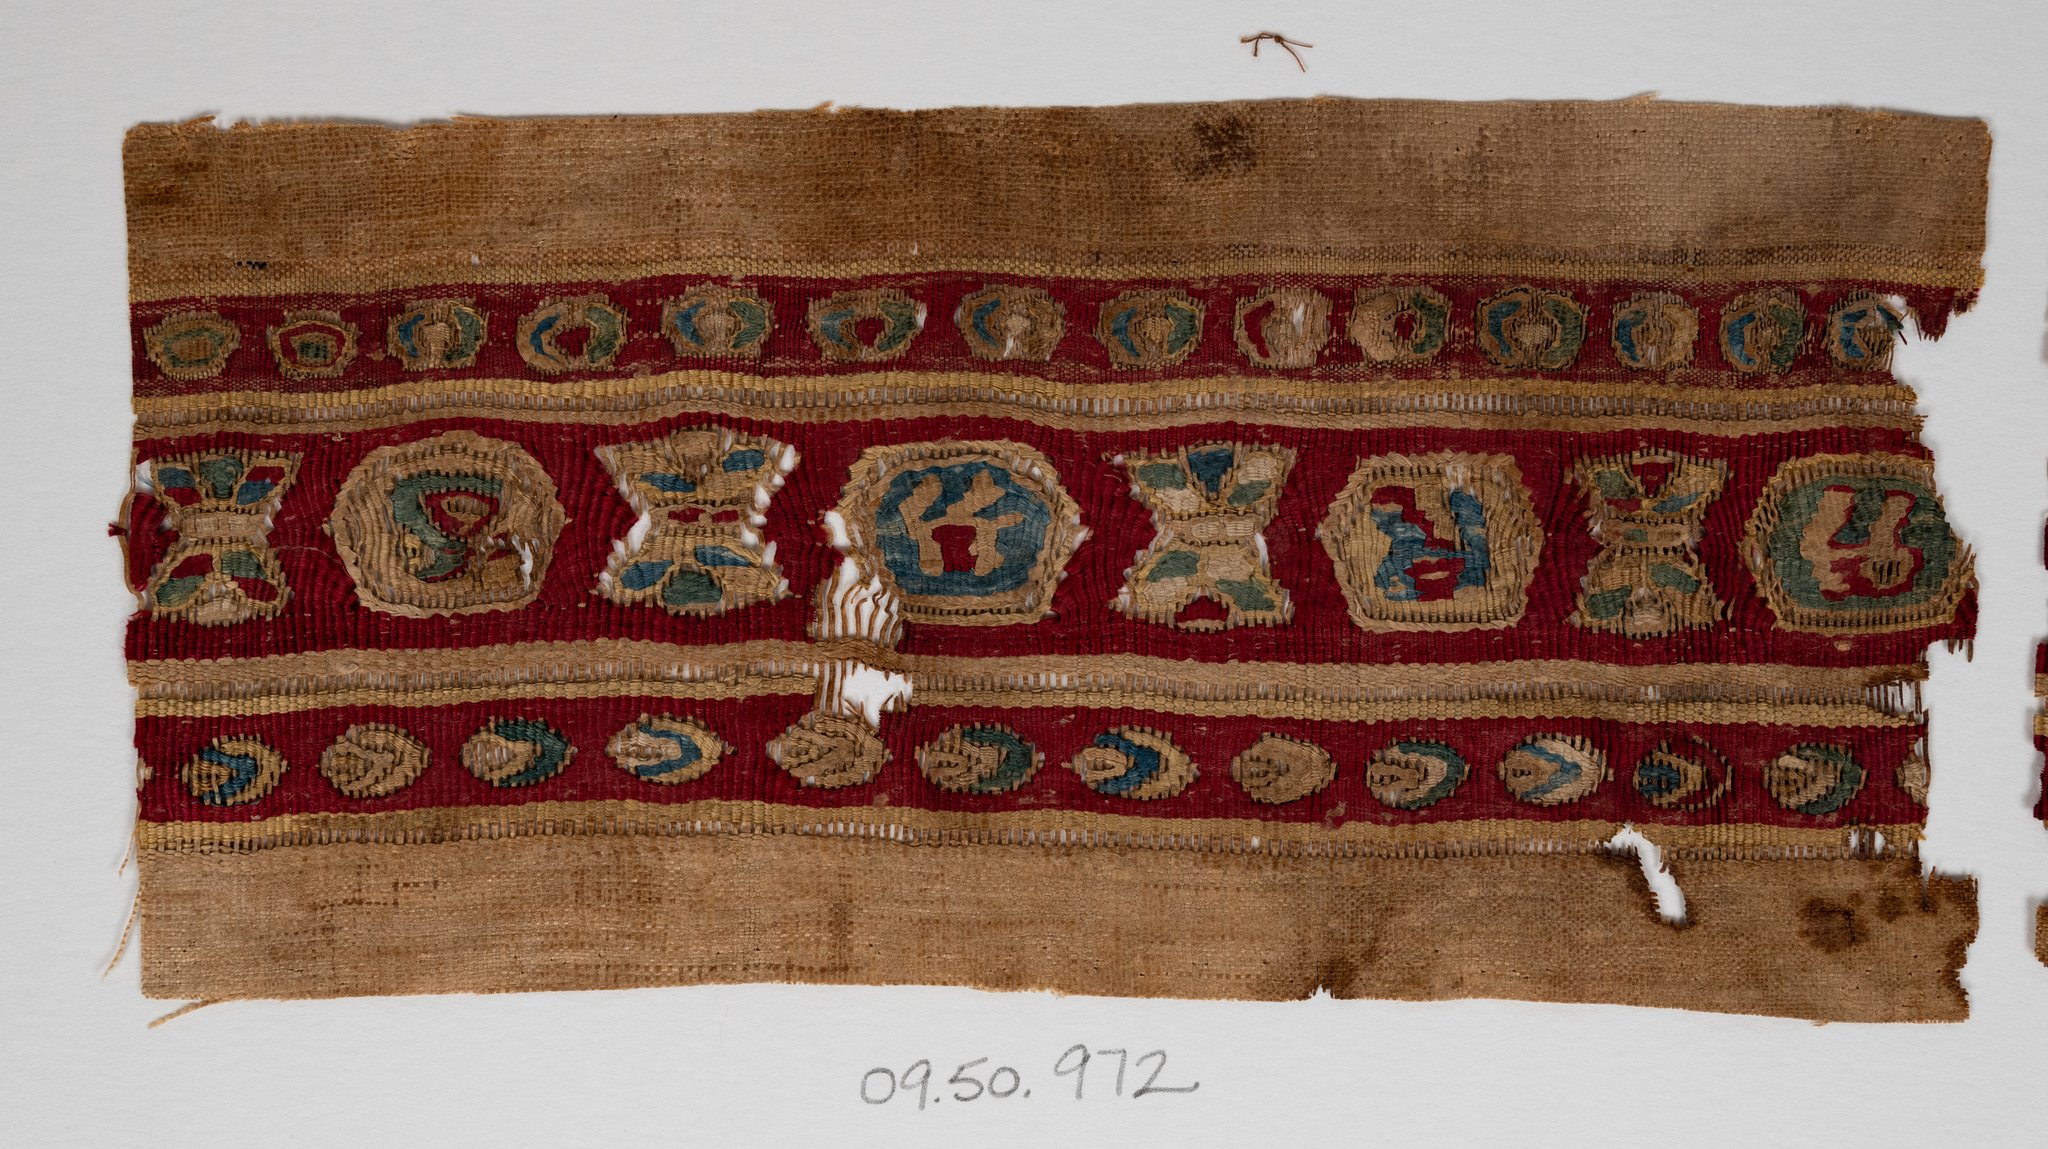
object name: textile fragment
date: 701-900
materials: linen, silk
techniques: embroidery, weave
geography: egypt